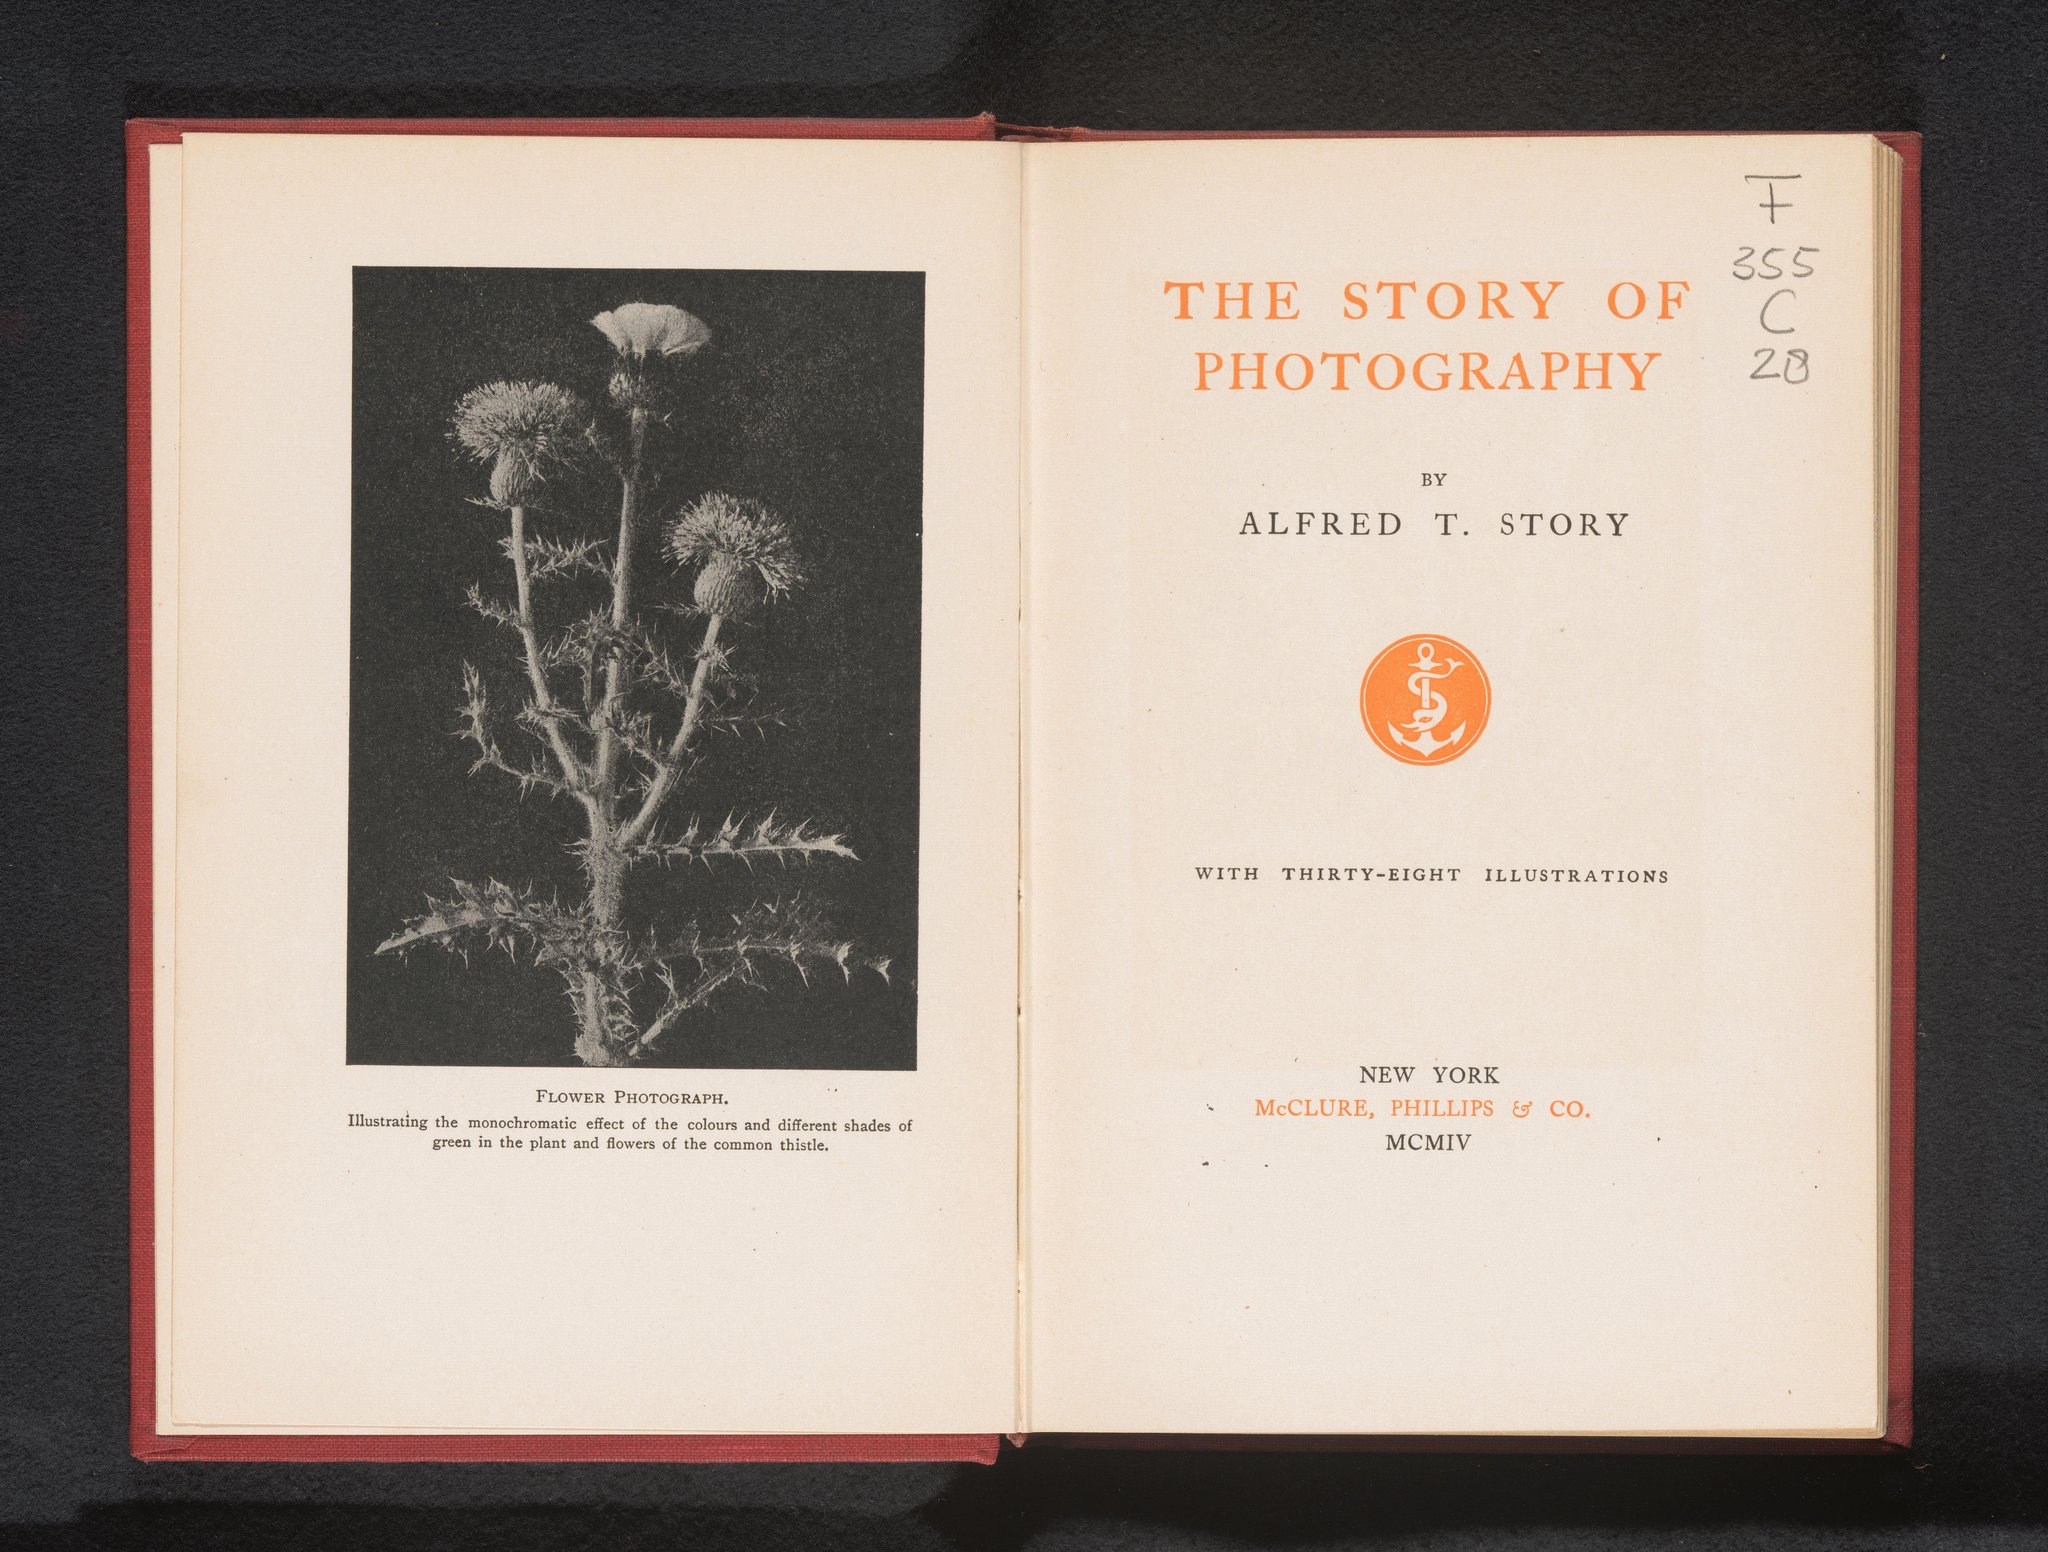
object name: photomechanical print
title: Distel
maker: Anonymous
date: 1894-1904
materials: paper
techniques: autotype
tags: plants and herbs: thistle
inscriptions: inscription: ‘Illustrating the monochromatic effect of the colours and different shades of green in the plant and flowers of the comon thistle.’